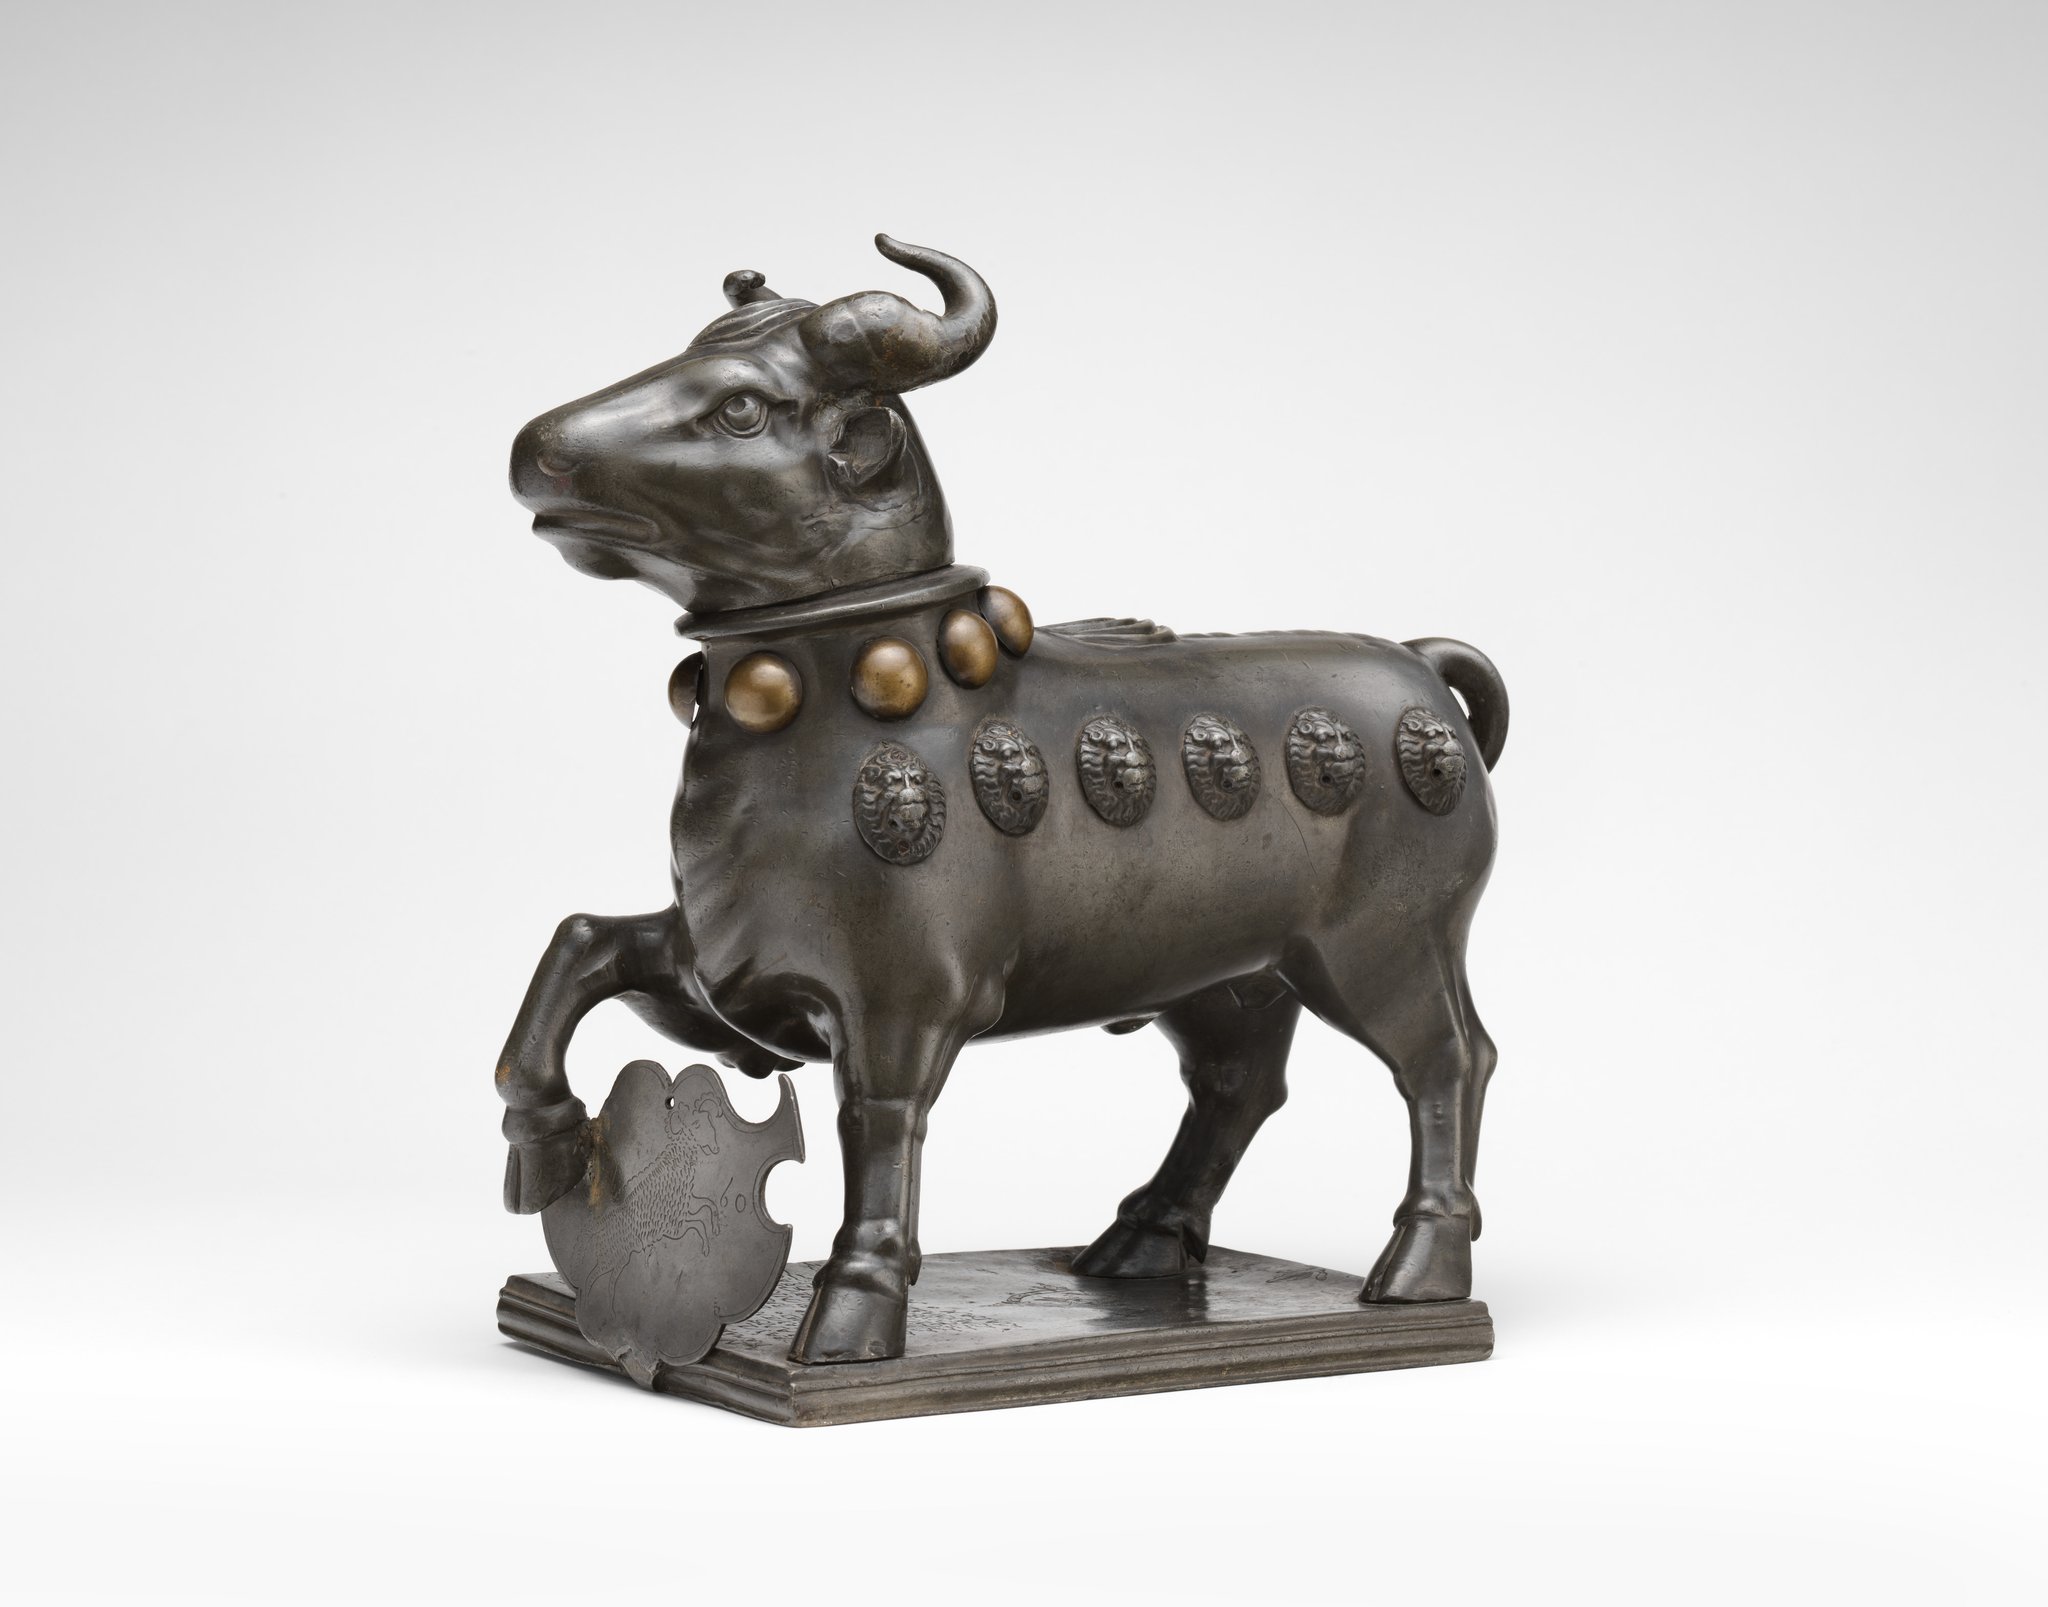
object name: guild vessel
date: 1801-1900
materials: pewter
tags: animals